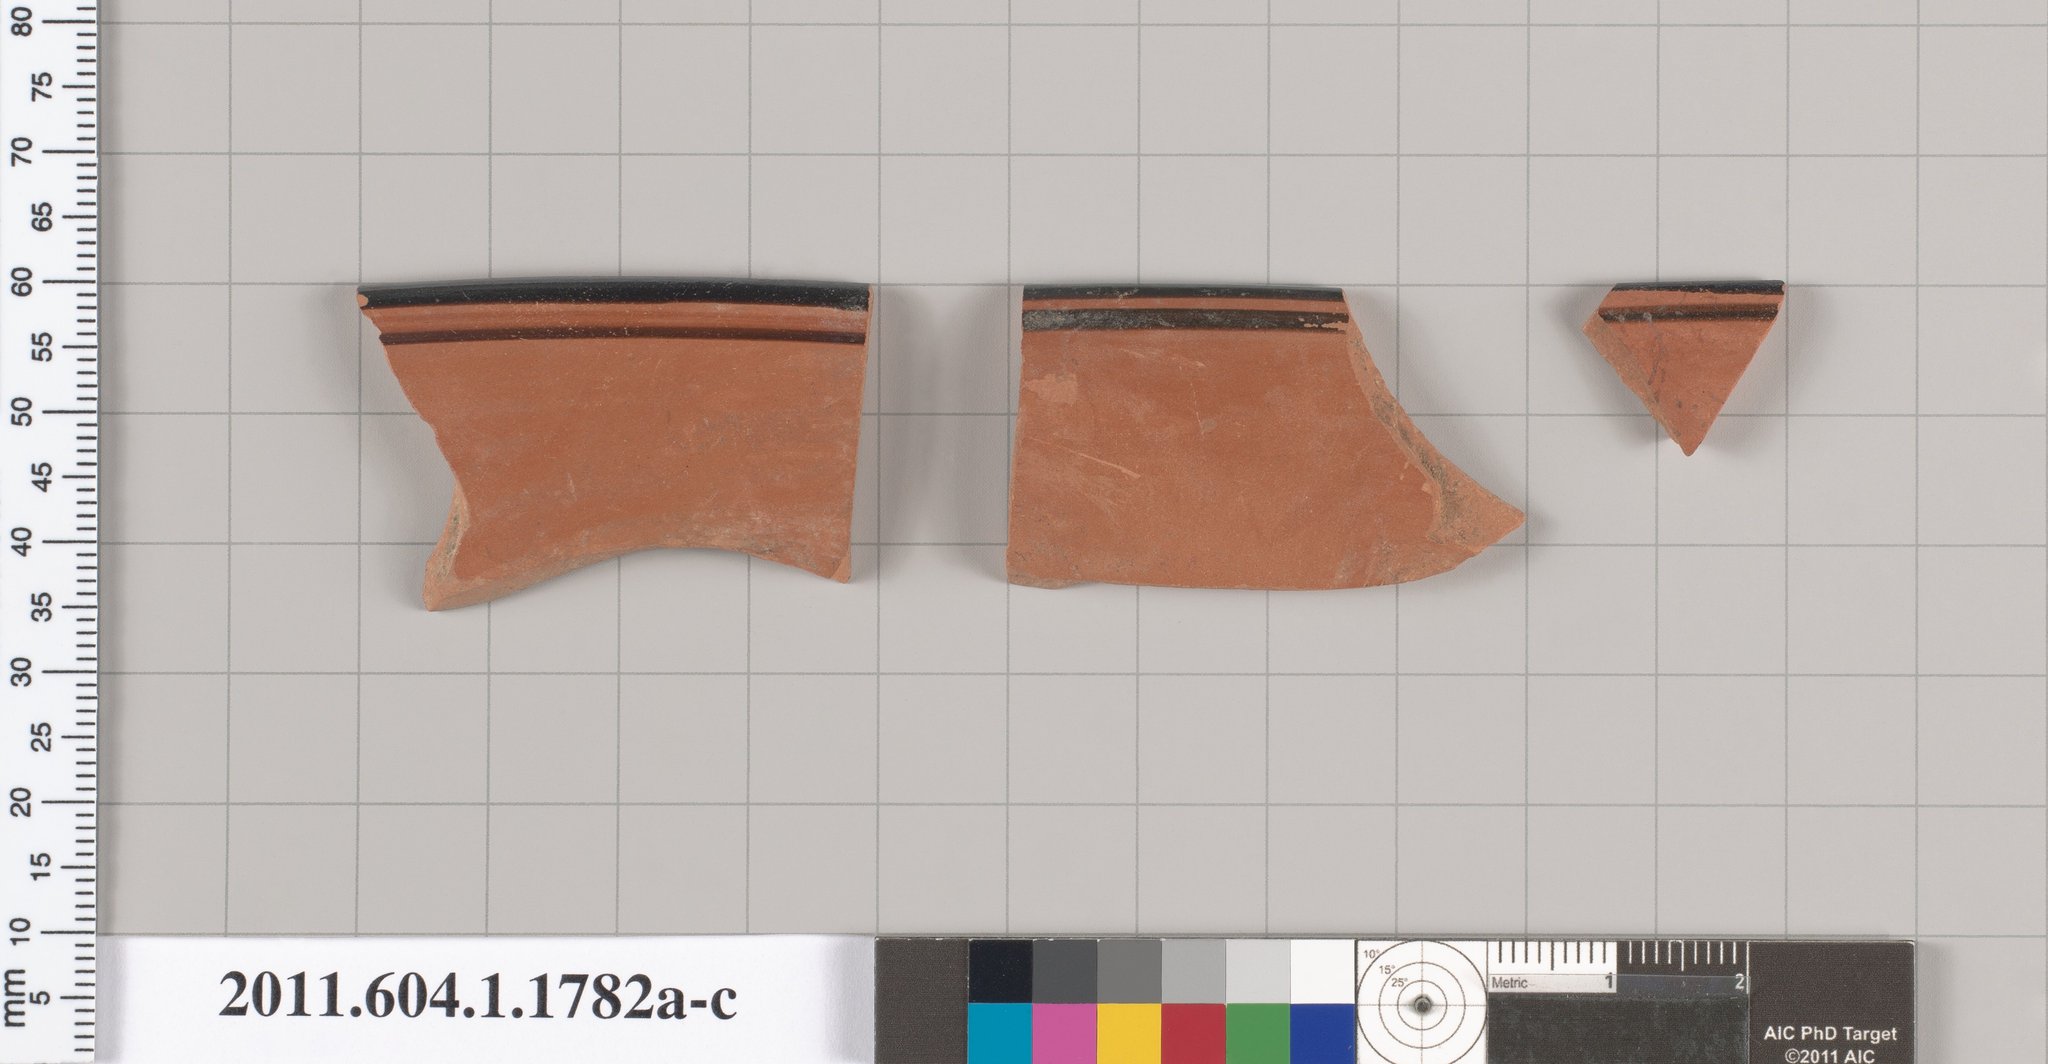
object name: kylix fragment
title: Terracotta rim fragments of kylikes(drinking cups)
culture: greek, attic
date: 500-401 BCE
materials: terracotta